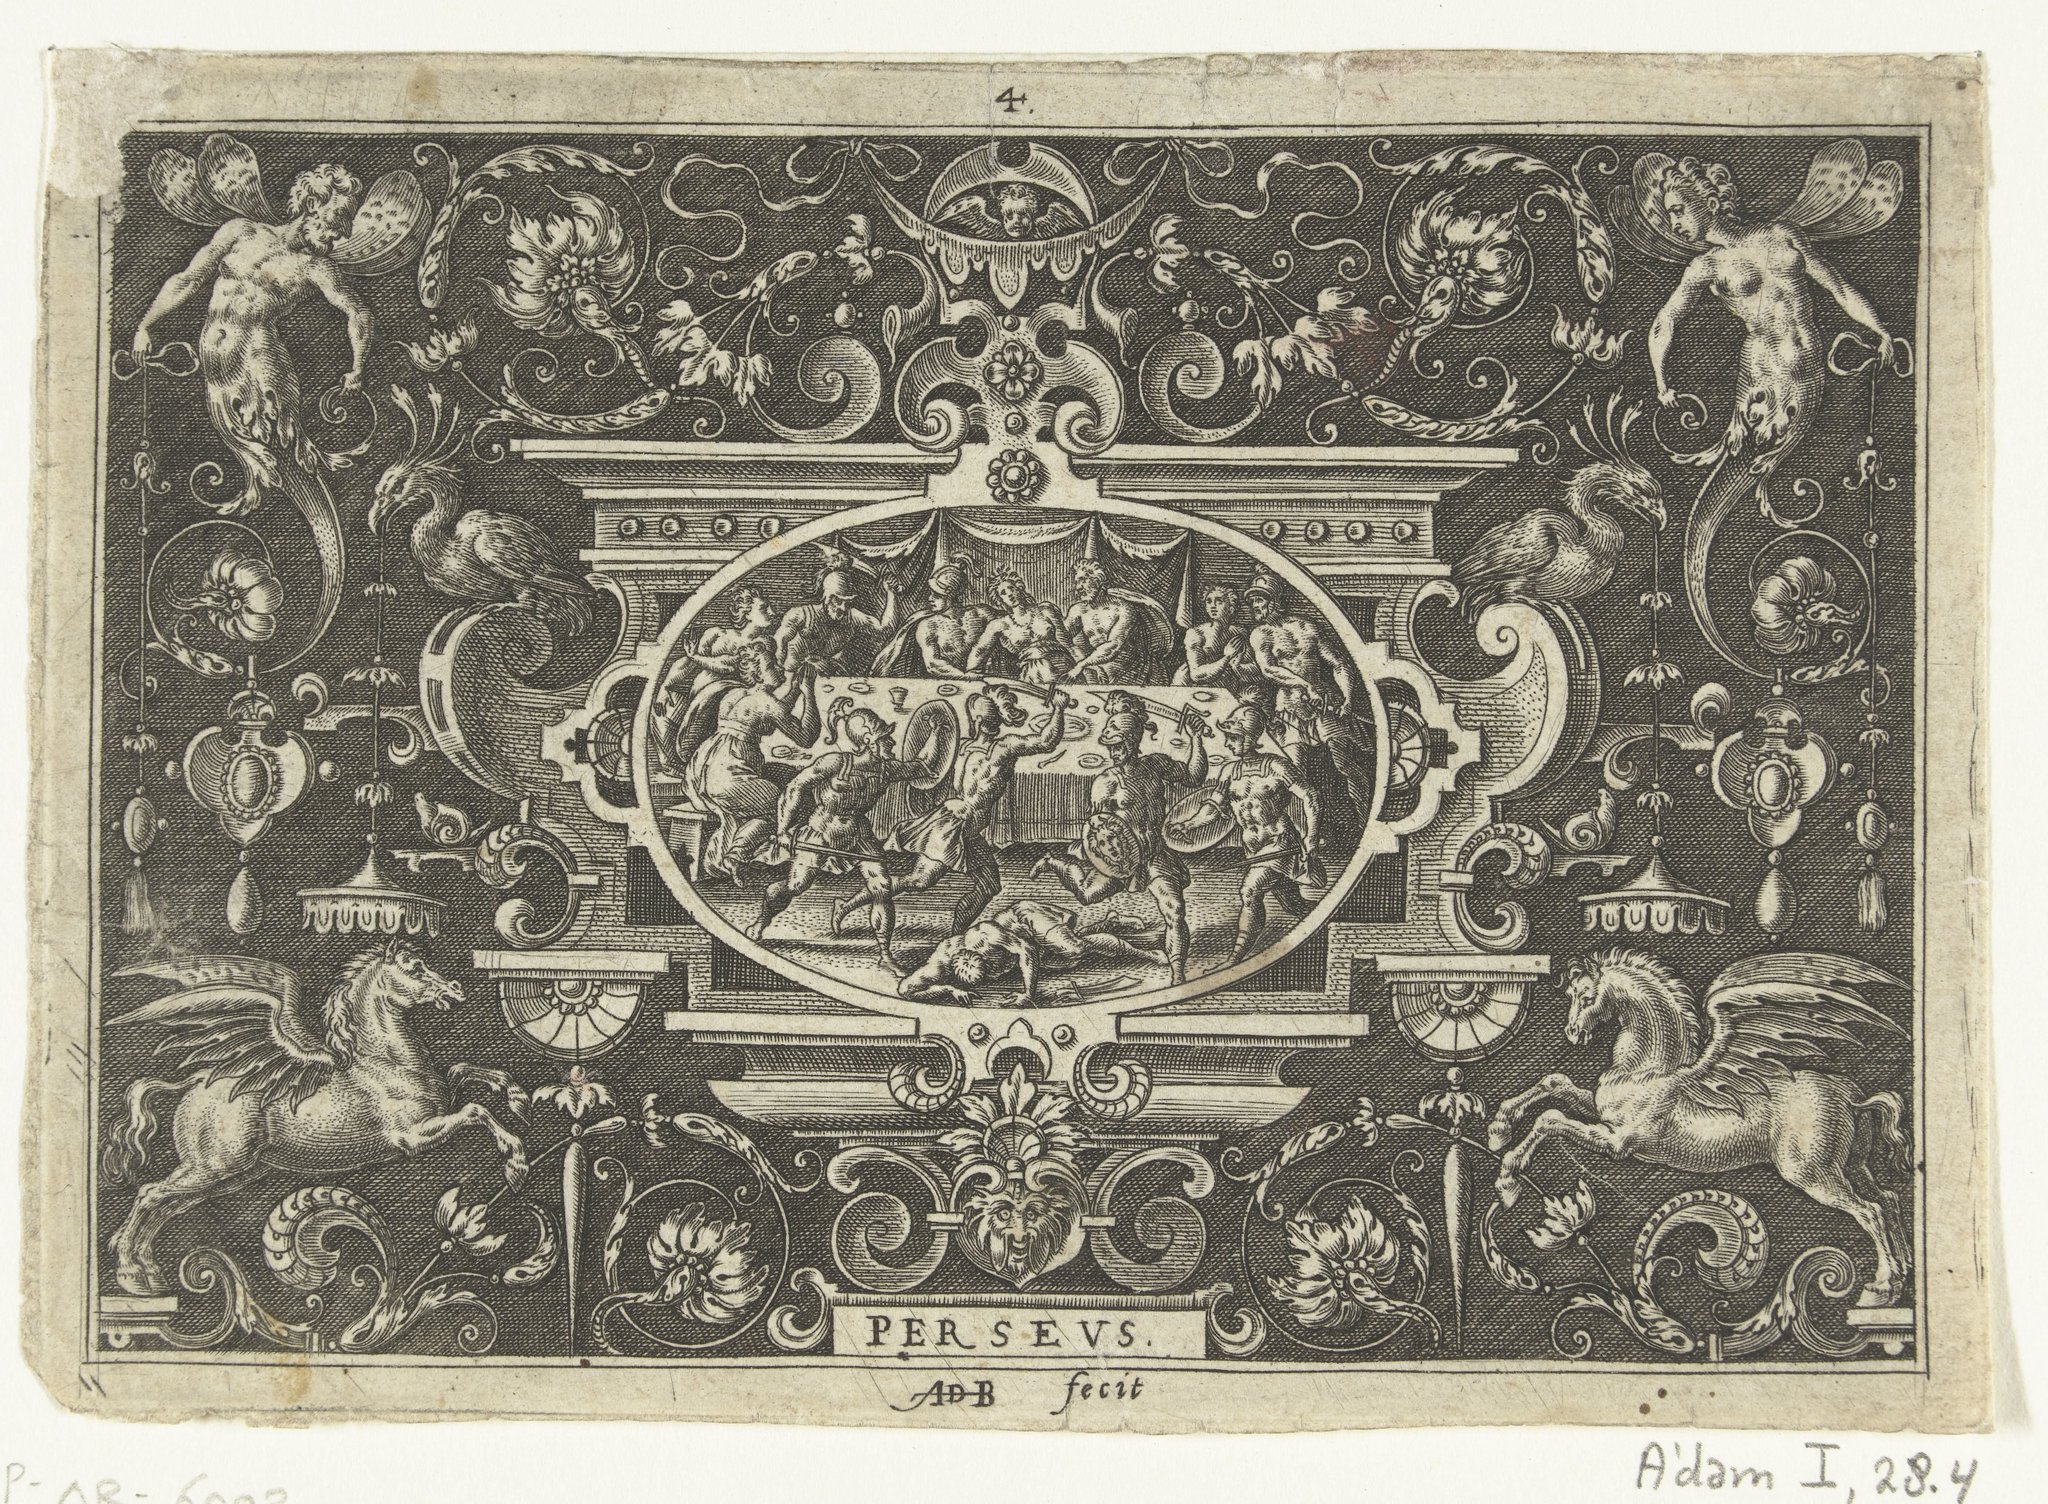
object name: print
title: PERSEUS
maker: abraham de bruyn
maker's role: print maker, publisher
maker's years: 1540-1587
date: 1584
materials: paper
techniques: engraving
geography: netherlands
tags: ornament ~ grotesque, ornament ~ cartouche, the wedding-feast of perseus and andromeda is interrupted by phineus, a former suitor; a fight ensues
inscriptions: number: ‘4’, signature: ‘ADB’, title: ‘PERSEUS’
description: Ovaal Cartouche in ornamentomlijsting met grotesken en twee gevleugelde paarden, tegen een gearceerde achtergrond. In het cartouche de huwelijksmaaltijd van Perseus en Andromeda, die wordt verstoord door Phineus.